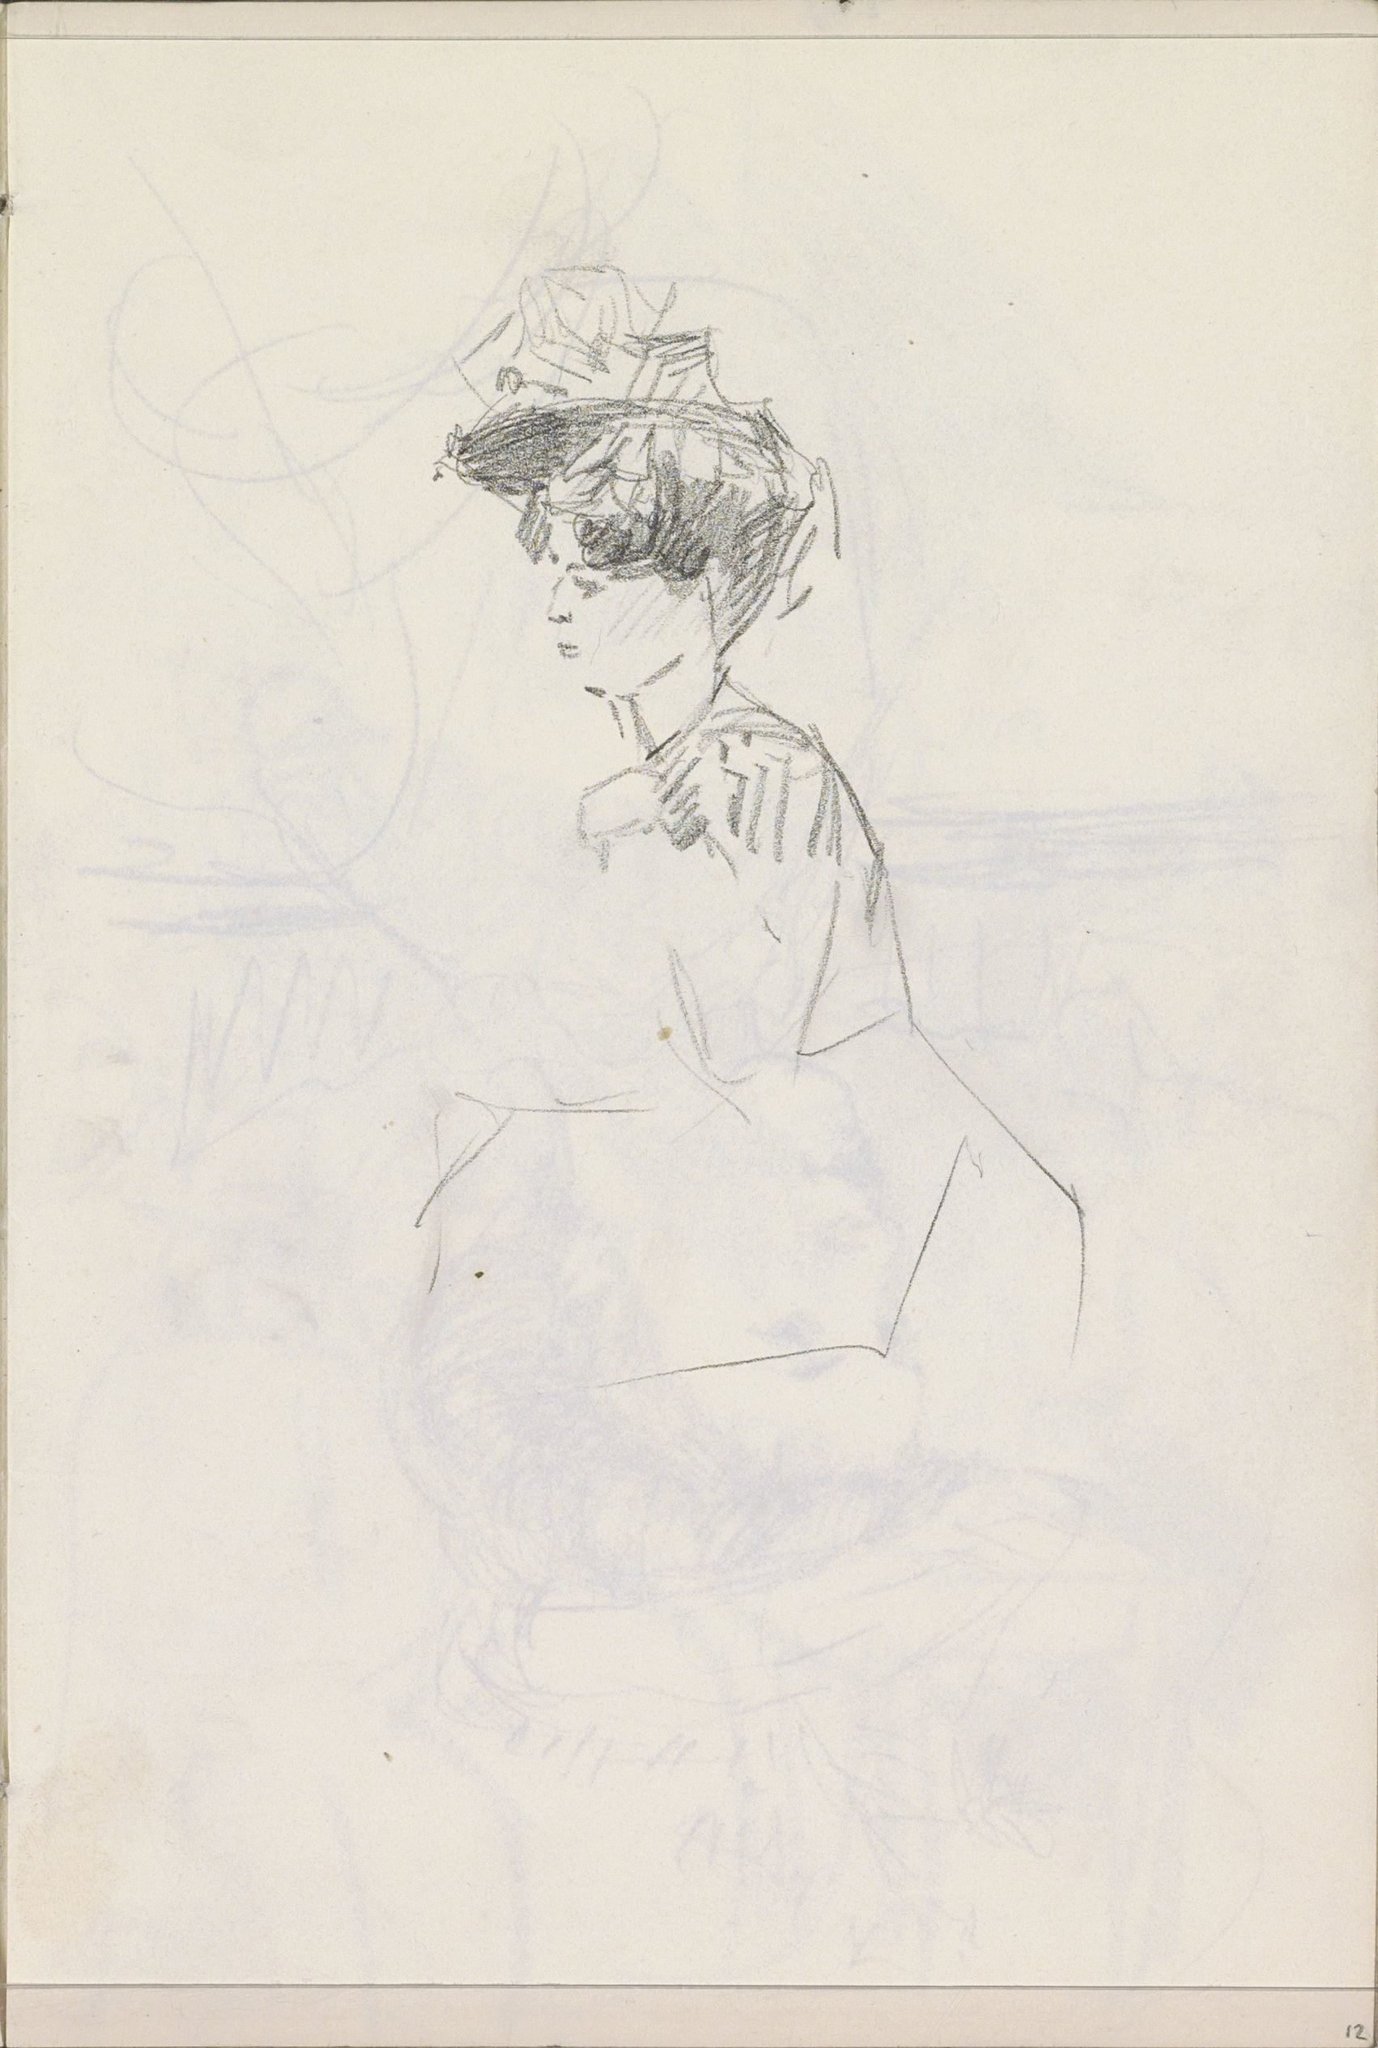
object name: sketchbook leaf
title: Zittende vrouw met hoed, in profiel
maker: isaac israels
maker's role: draughtsman, painter, print maker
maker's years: 1865-1934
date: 1875-1934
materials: paper, pencil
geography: paris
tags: head-gear: hat (+ women's clothes), adult woman (+ sitting)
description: Blad 12 recto uit schetsboek L met 42 bladen.